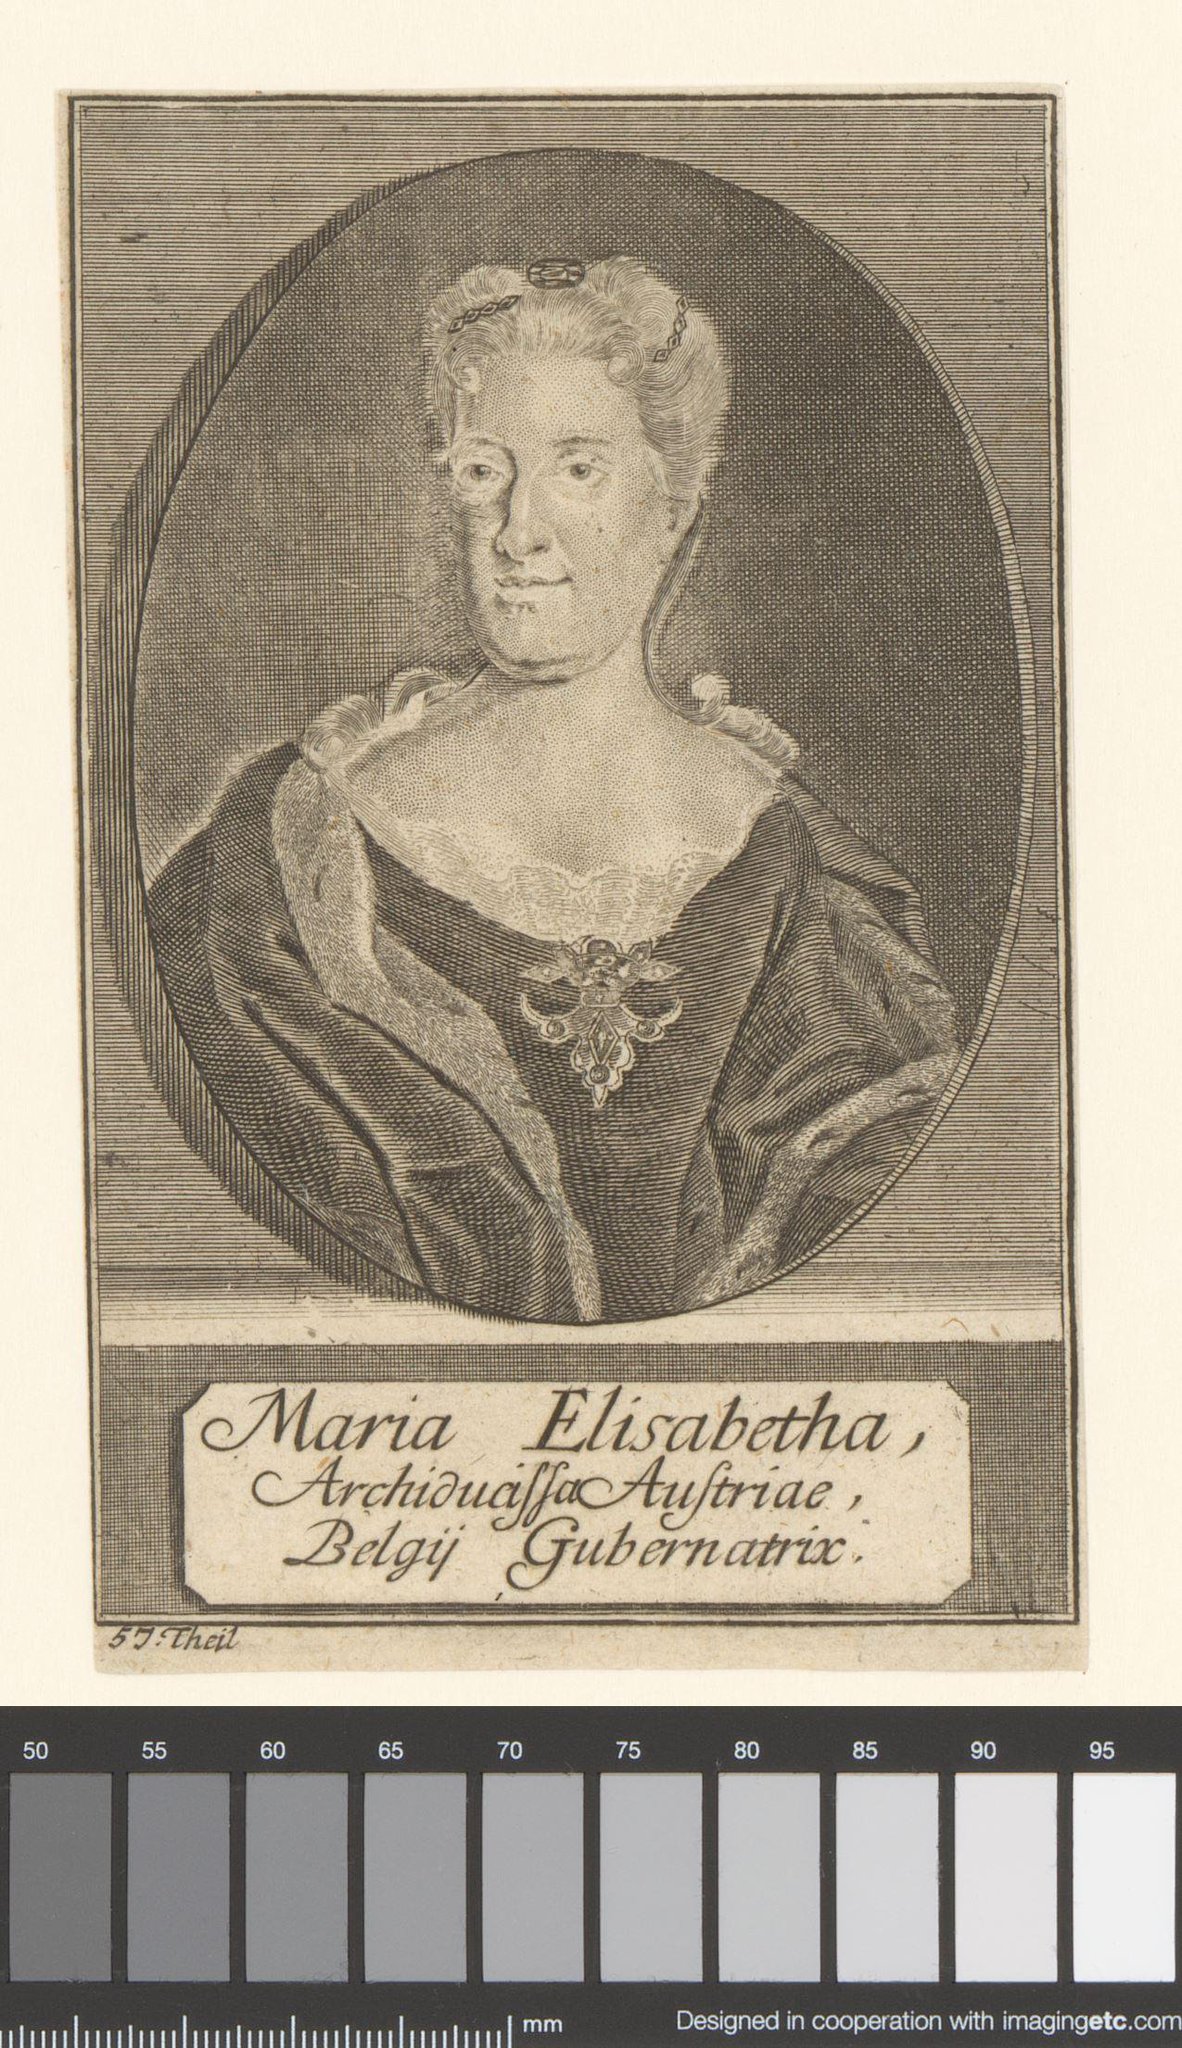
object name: print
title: Portret van Maria Elisabeth, aartshertogin van Oostenrijk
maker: michael rössler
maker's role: print maker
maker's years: 1705-1777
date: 1724-1777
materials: paper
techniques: engraving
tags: historical persons - bb - woman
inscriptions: collector's mark: Lugt 2228